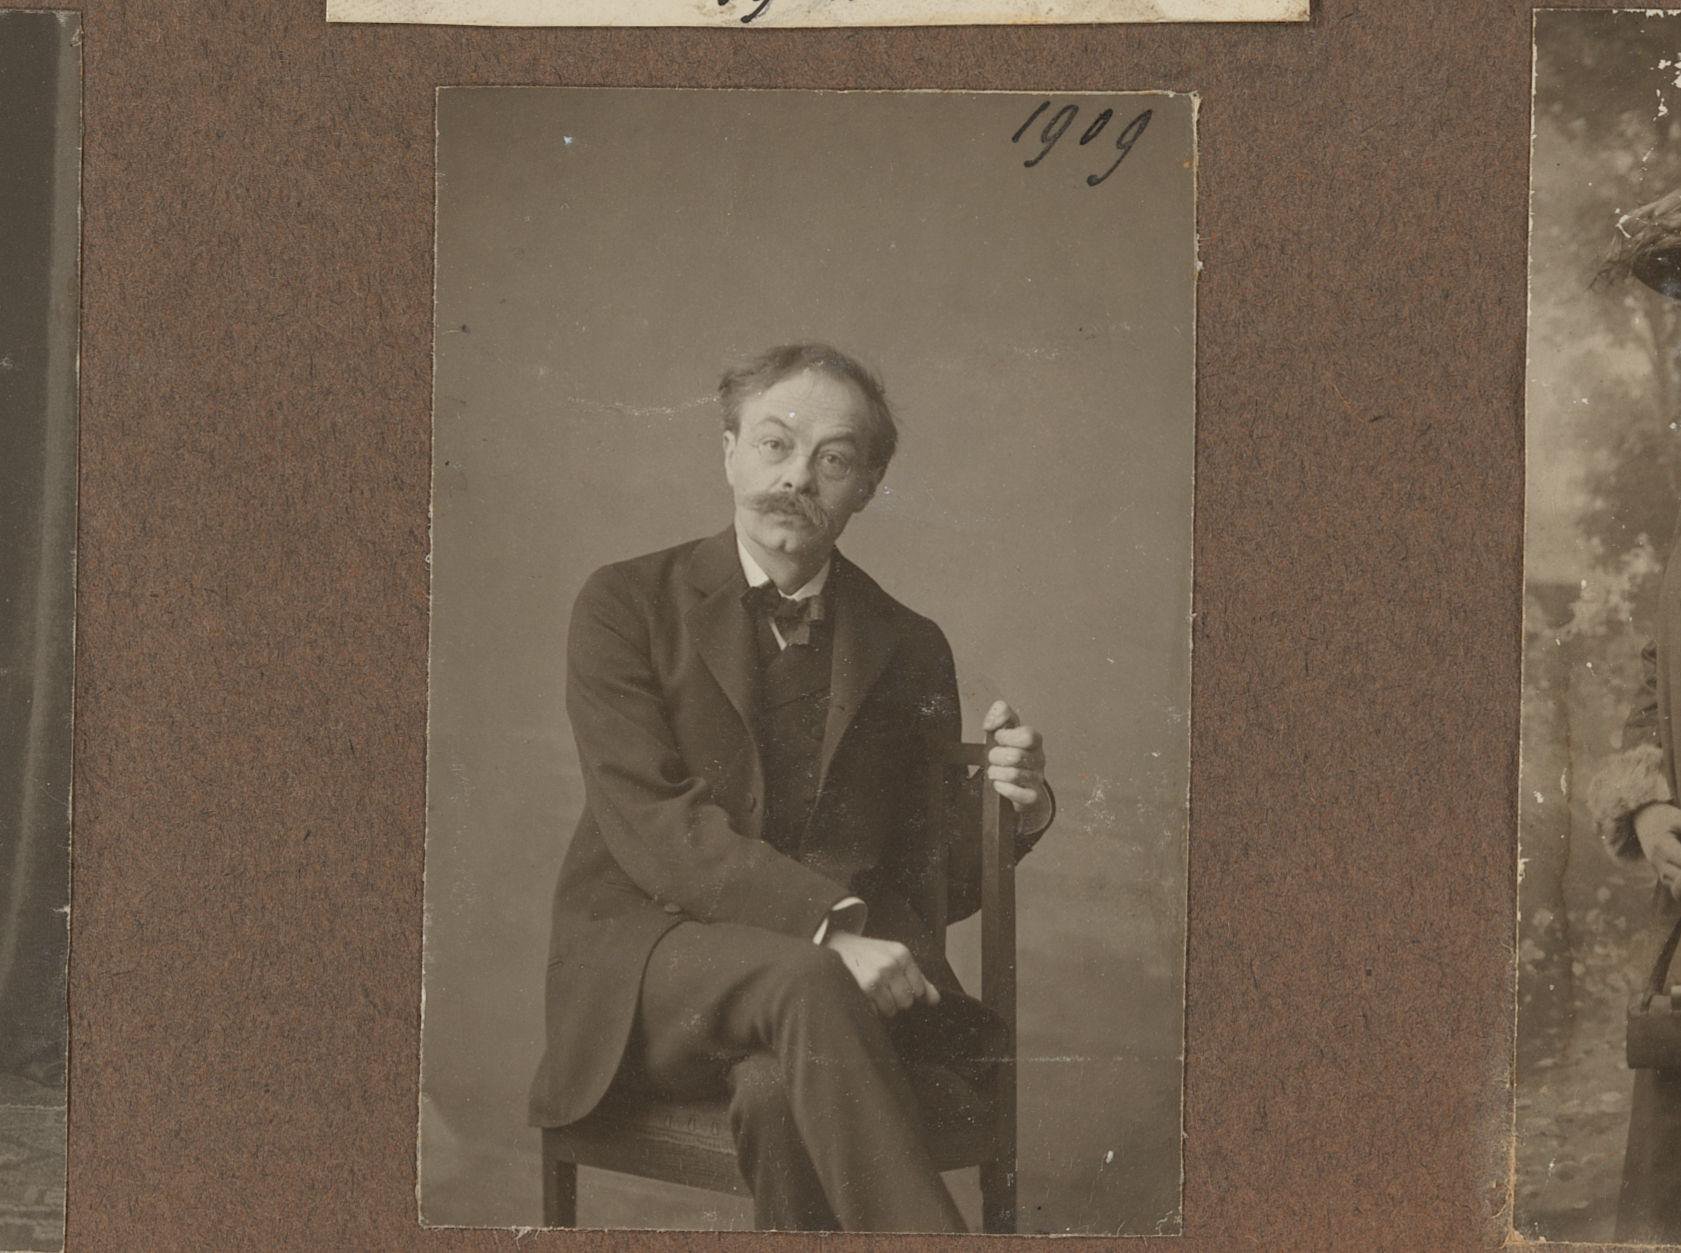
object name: photograph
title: Alphons Diepenbrock, zittend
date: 1909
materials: photographic support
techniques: photography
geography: amsterdam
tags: amsterdam, alphons diepenbrock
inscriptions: date: ‘1909’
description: Foto op bruin albumblad 24 van familiealbum van Alphons Diepenbrock.